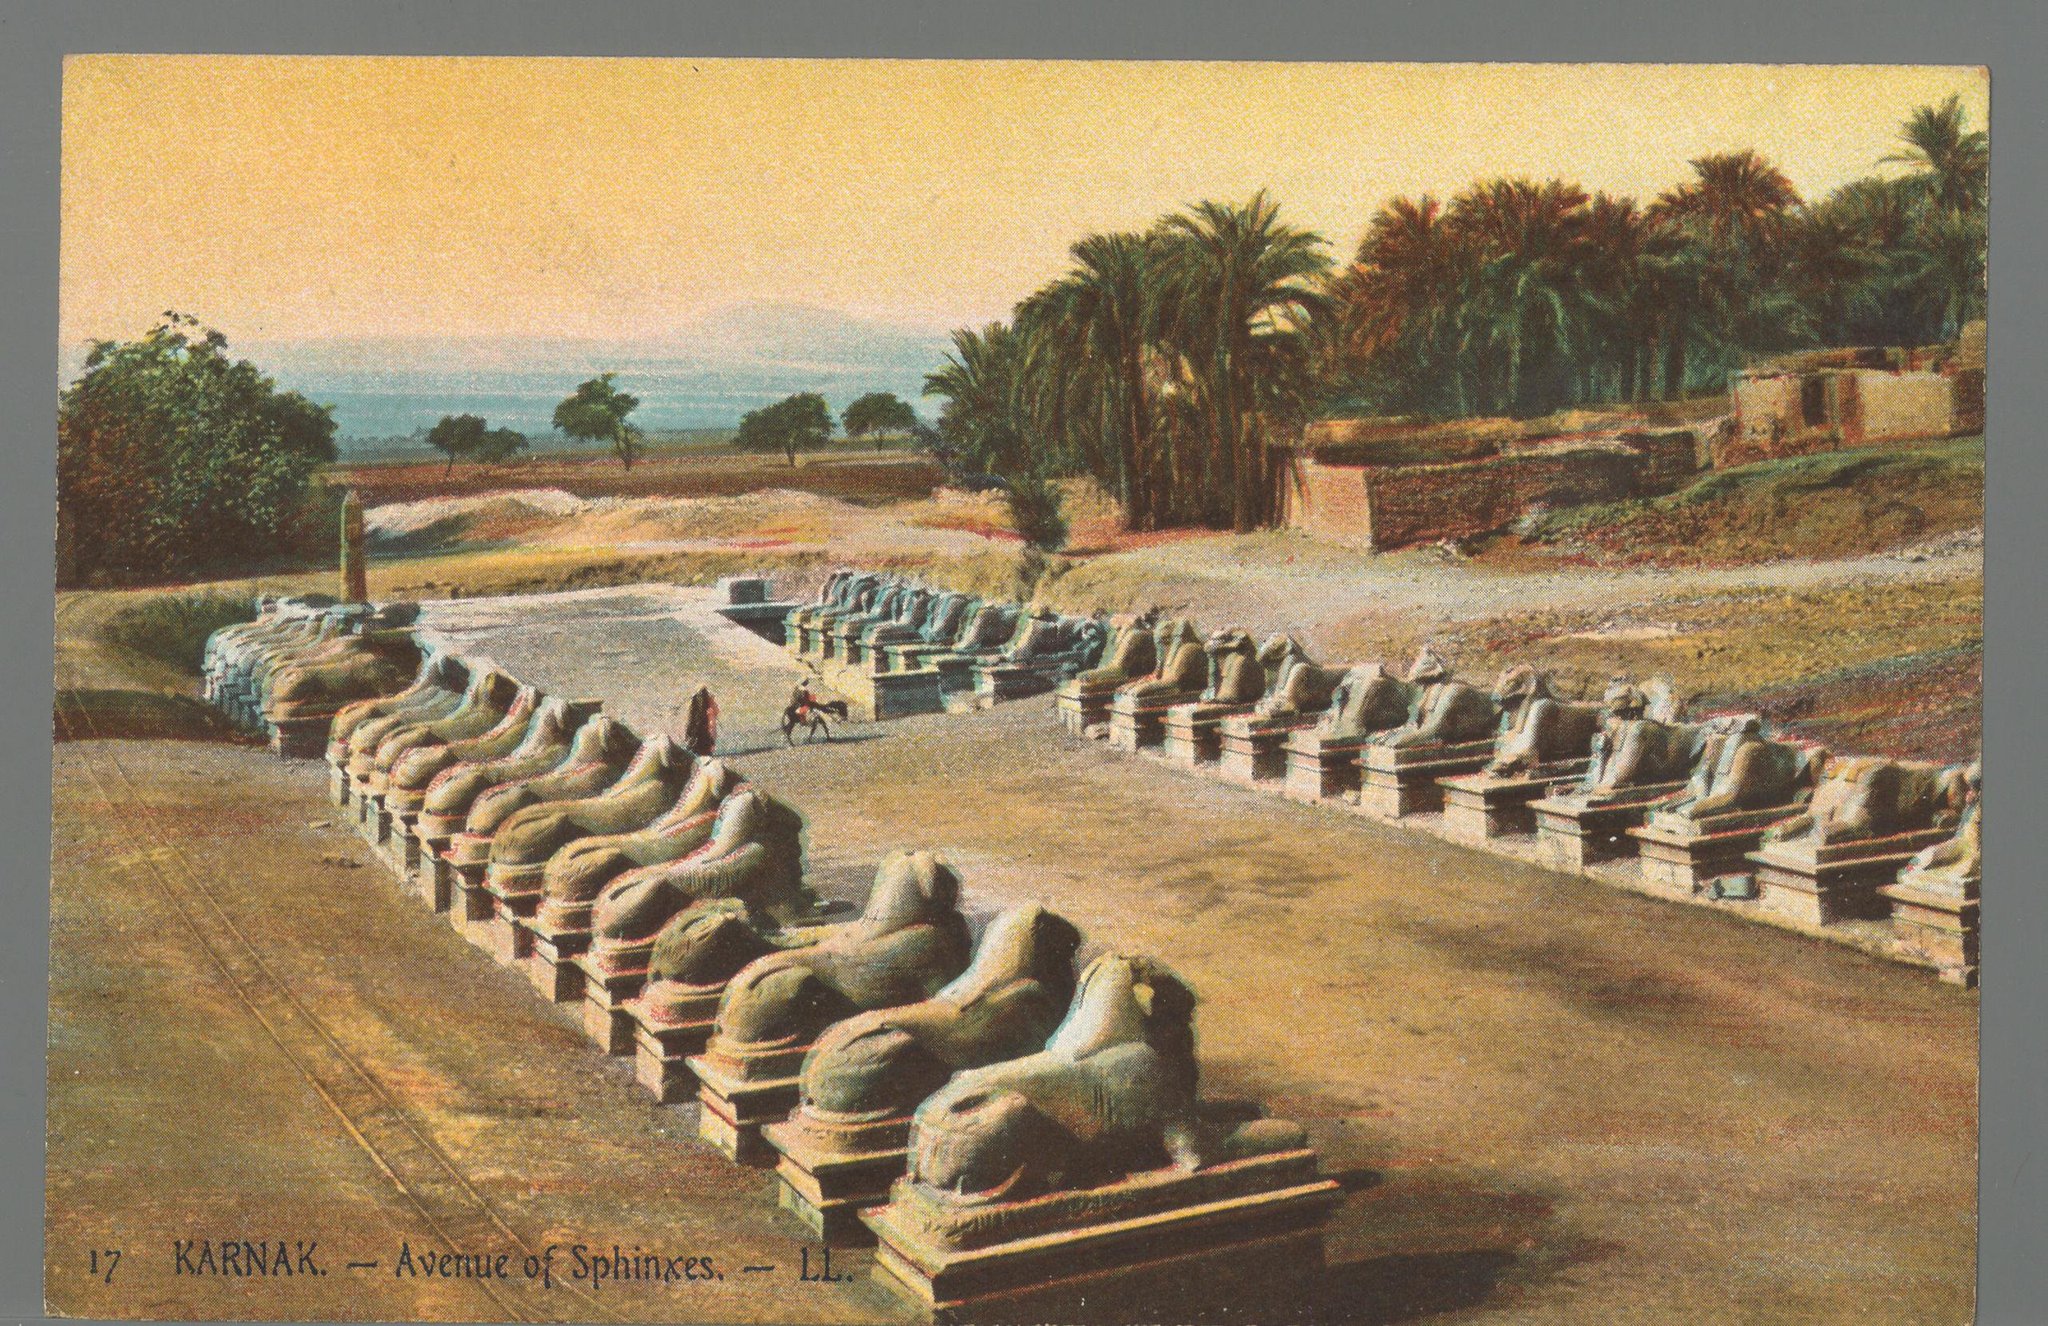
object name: photomechanical print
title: Karnak - Avenue of Sphinxes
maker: Anonymous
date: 1907-1930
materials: cardboard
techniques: lithograph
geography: karnak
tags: sphinx (lion/woman); 'sfinge' (ripa), statues, paintings, etc. ~ objects of worship (egyptian religion), avenue, boulevard, promenade, esplanade